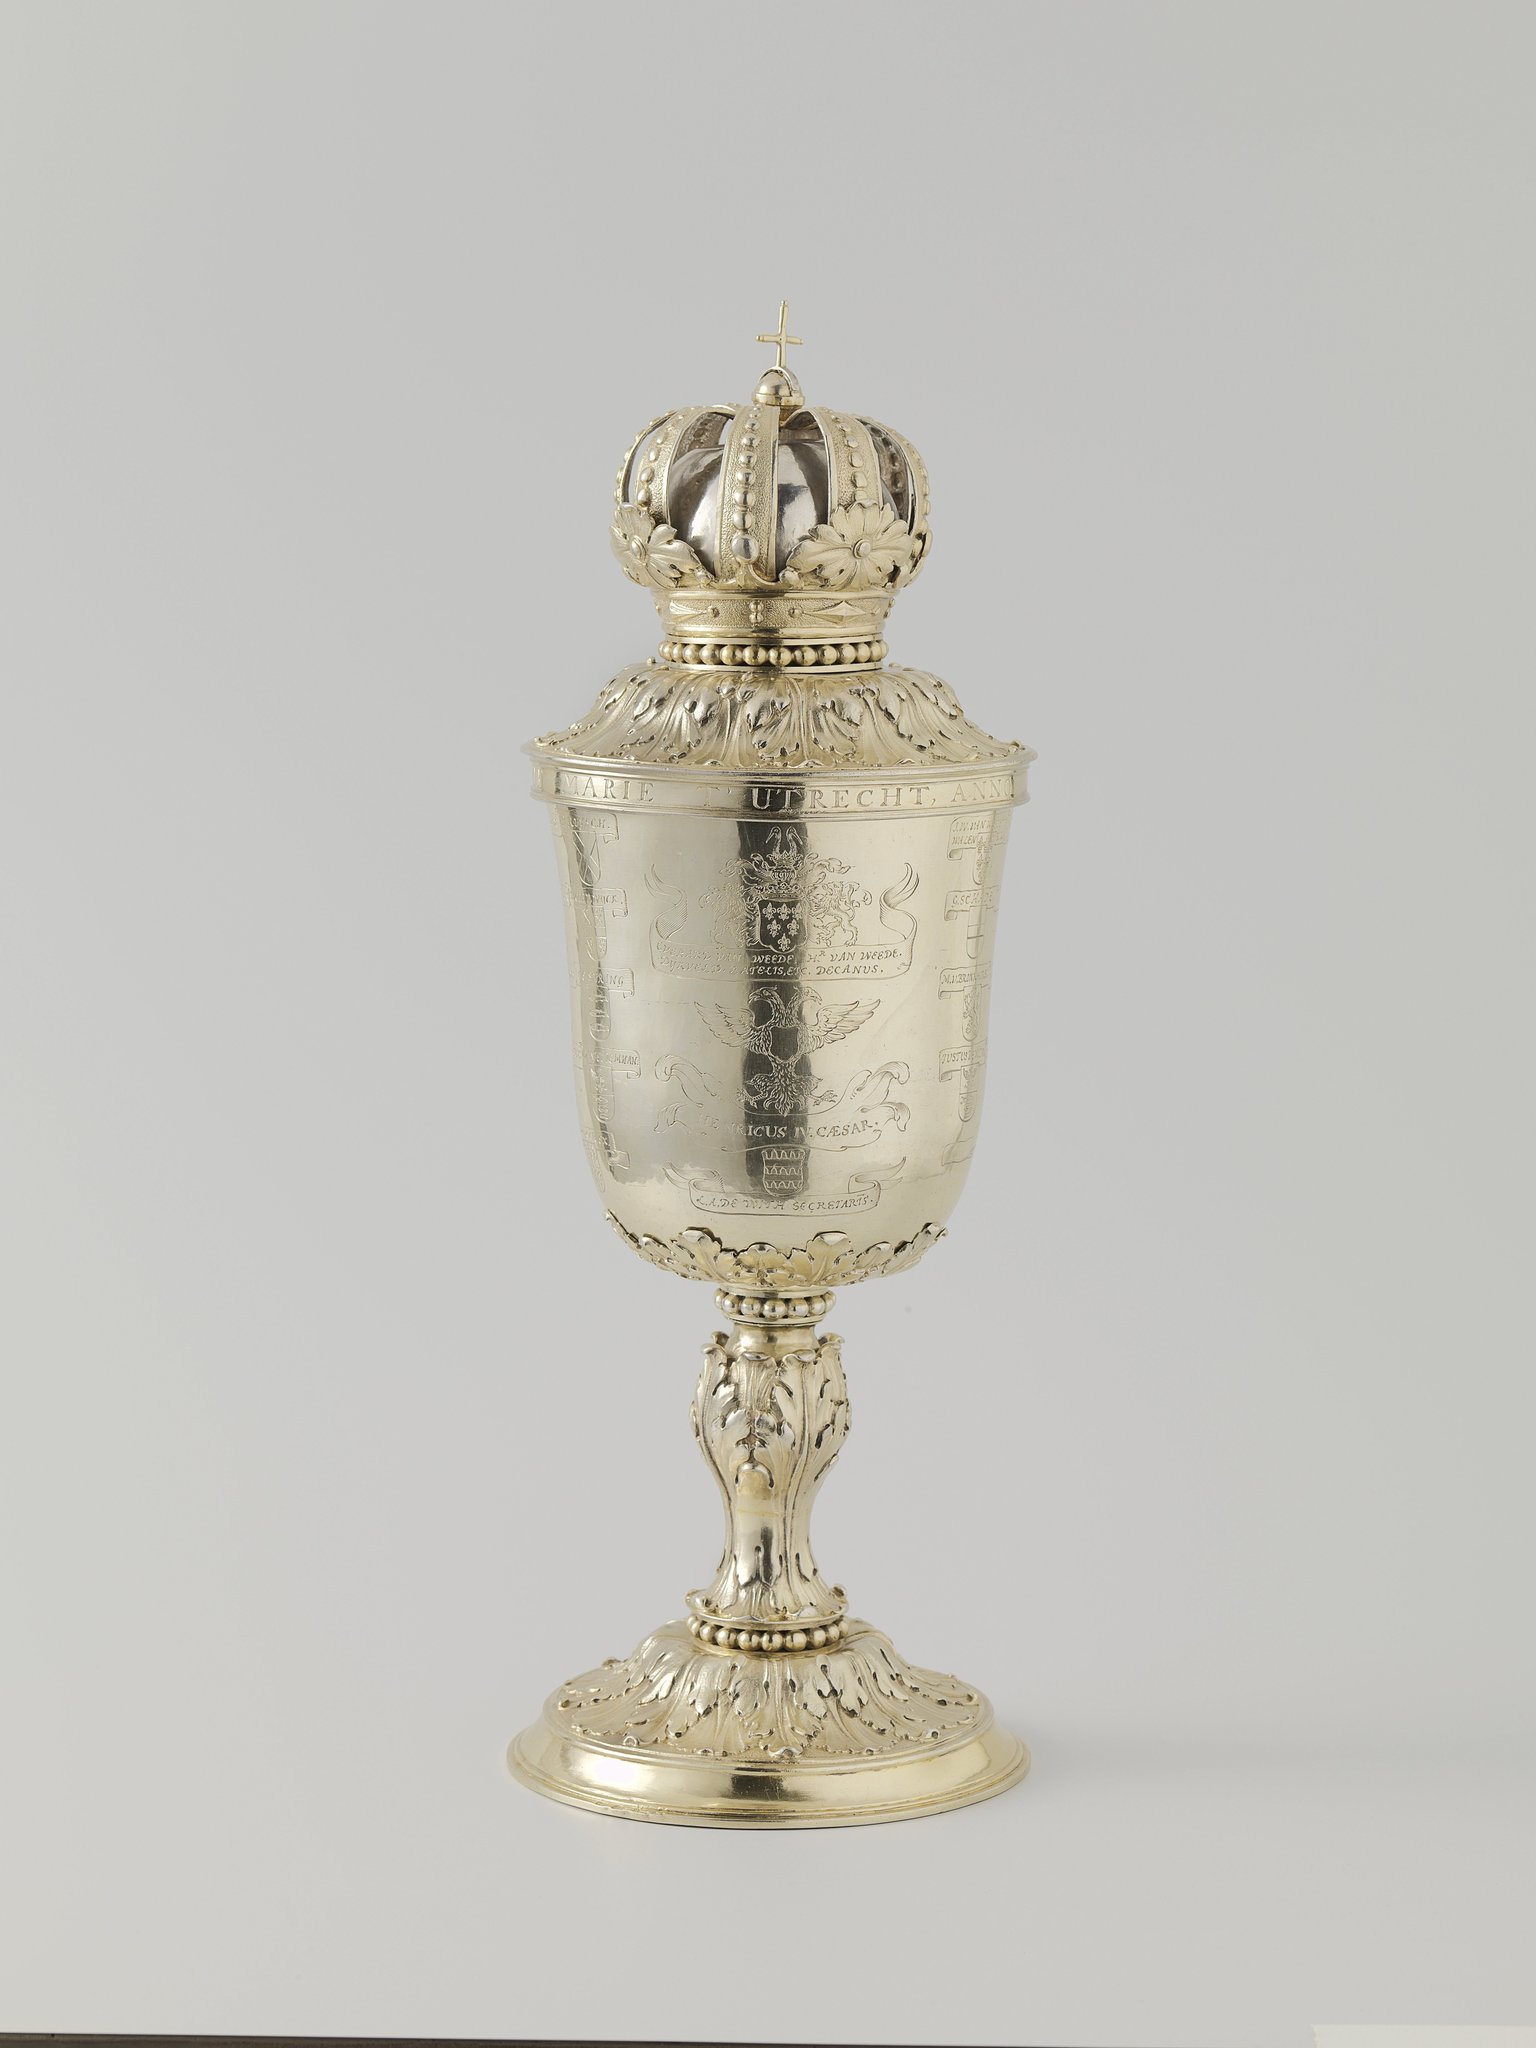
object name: cup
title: Beker van het kapittel van St. Marie te Utrecht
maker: thijmen van leeuwen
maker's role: silversmith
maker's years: -1705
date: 1686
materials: silver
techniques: gilding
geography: utrecht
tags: crown (symbol of sovereignty), acanthus ~ ornament, utrecht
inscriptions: mark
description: Cup, silver-gilt, from the Chapter of St Mary's, Utrecht. Utrecht, 1686 by Thymen van Leeuwen.